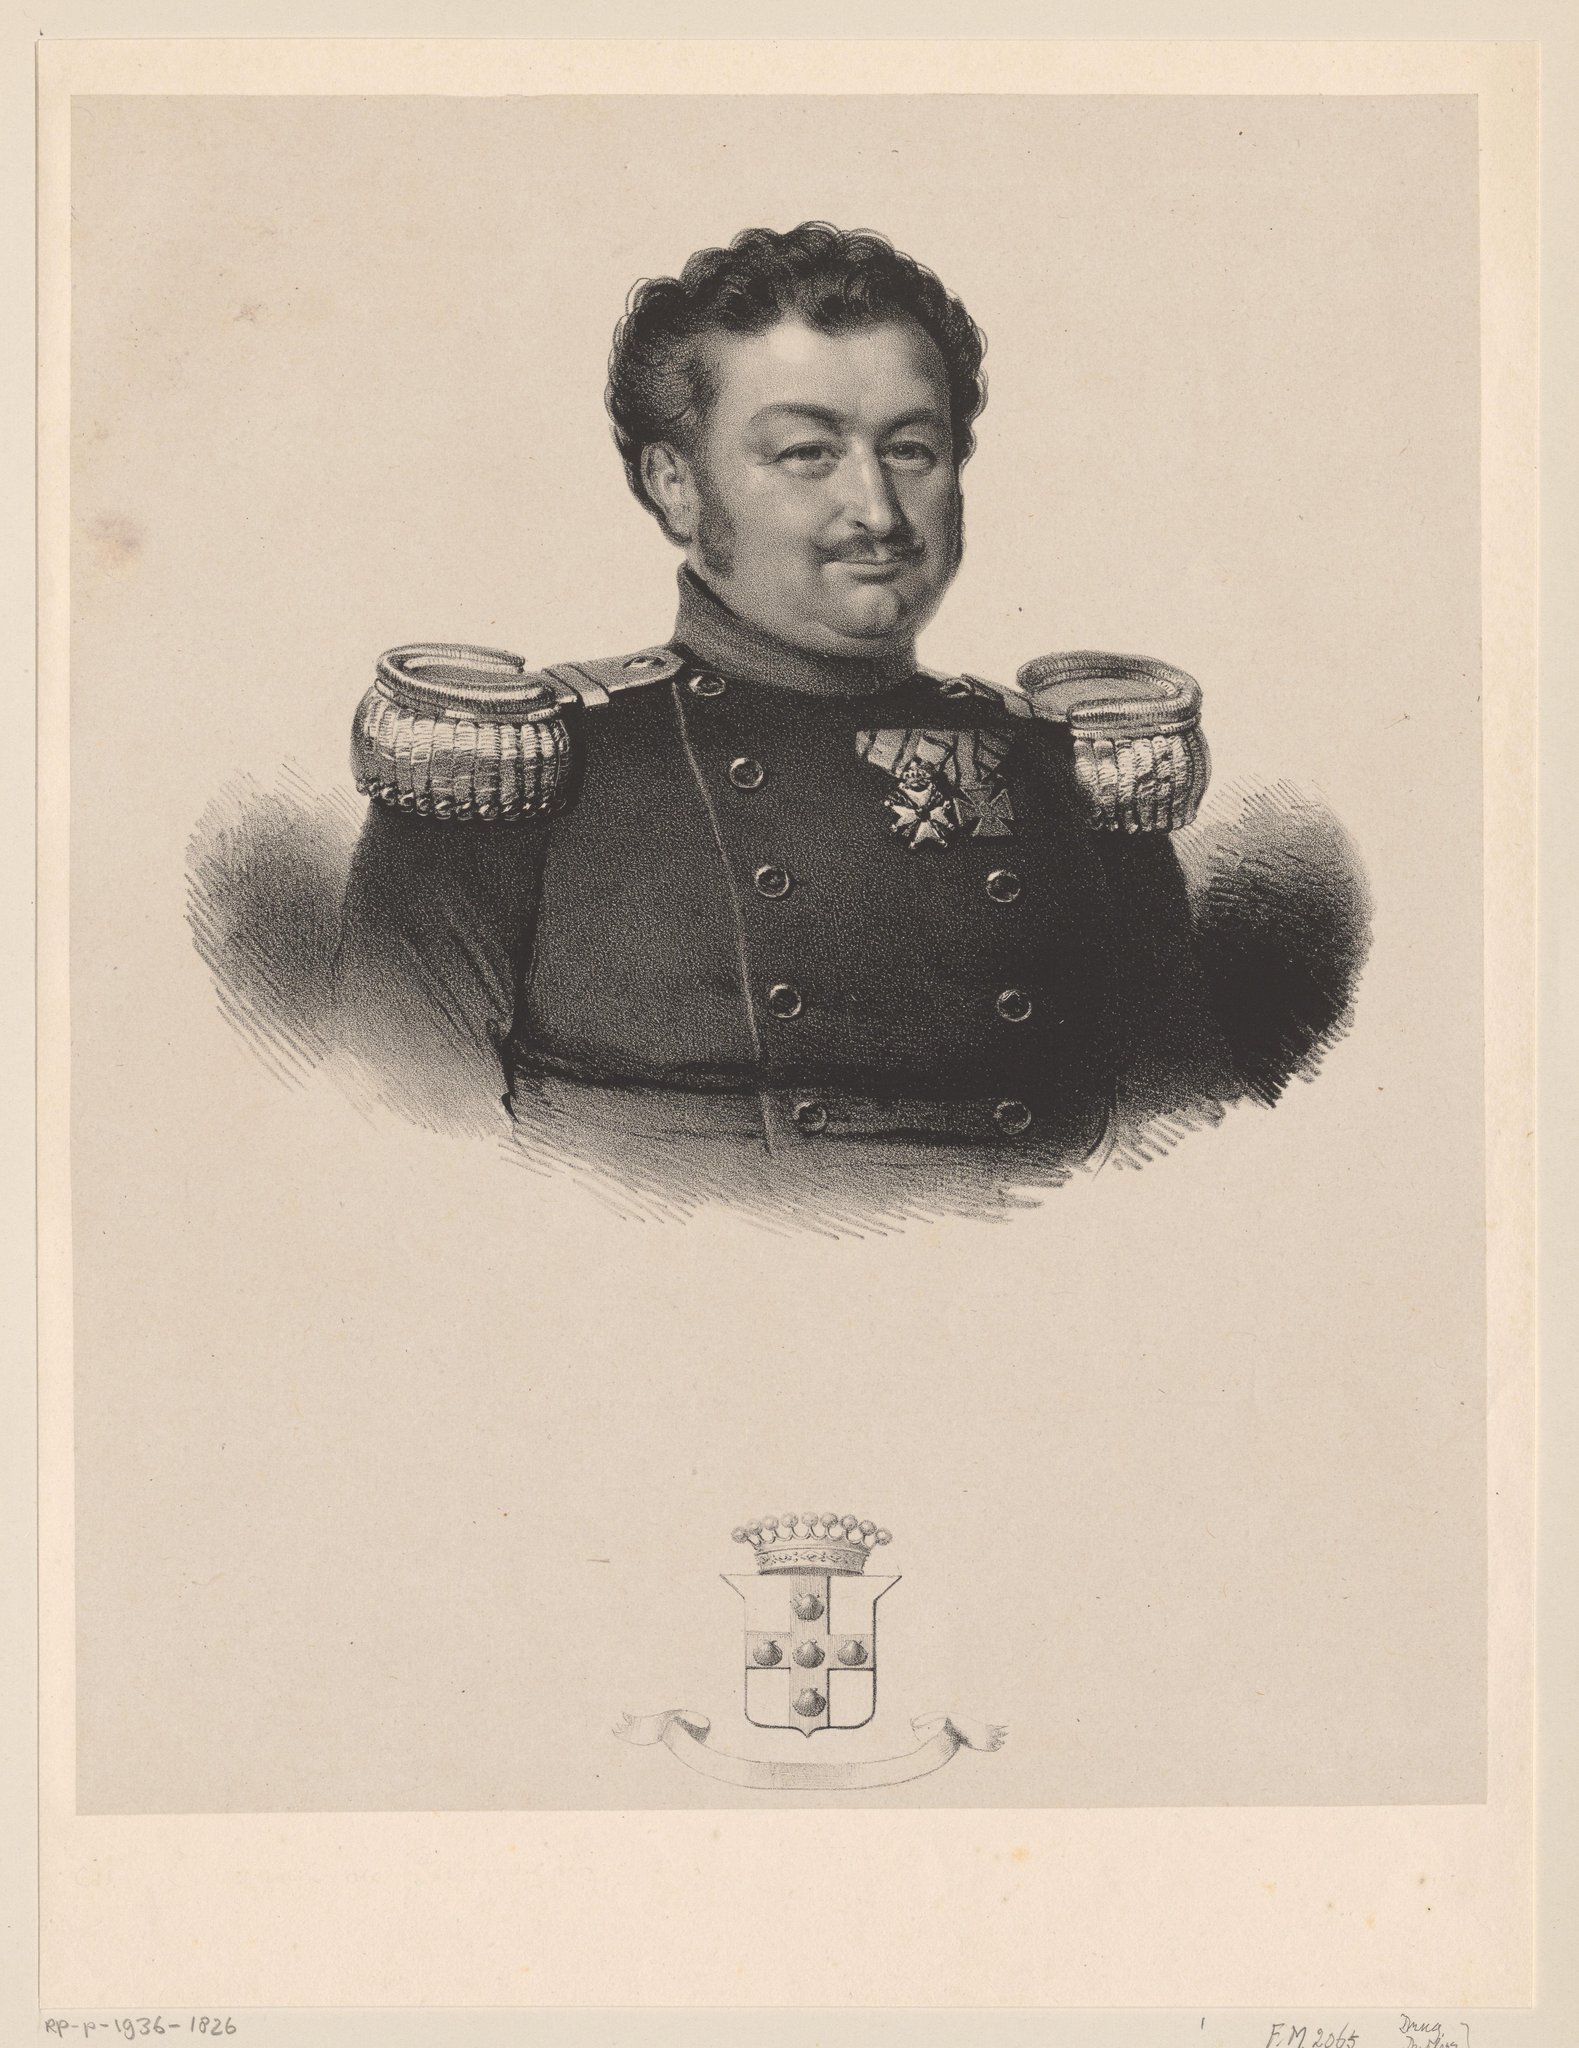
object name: print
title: Portret van Nicolas Emmanuel Frederic baron von Gumoëns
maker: Anonymous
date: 1810-1910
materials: paper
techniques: lithograph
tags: commander-in-chief, general, marshal, historical persons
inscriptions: collector's mark: Lugt 2228